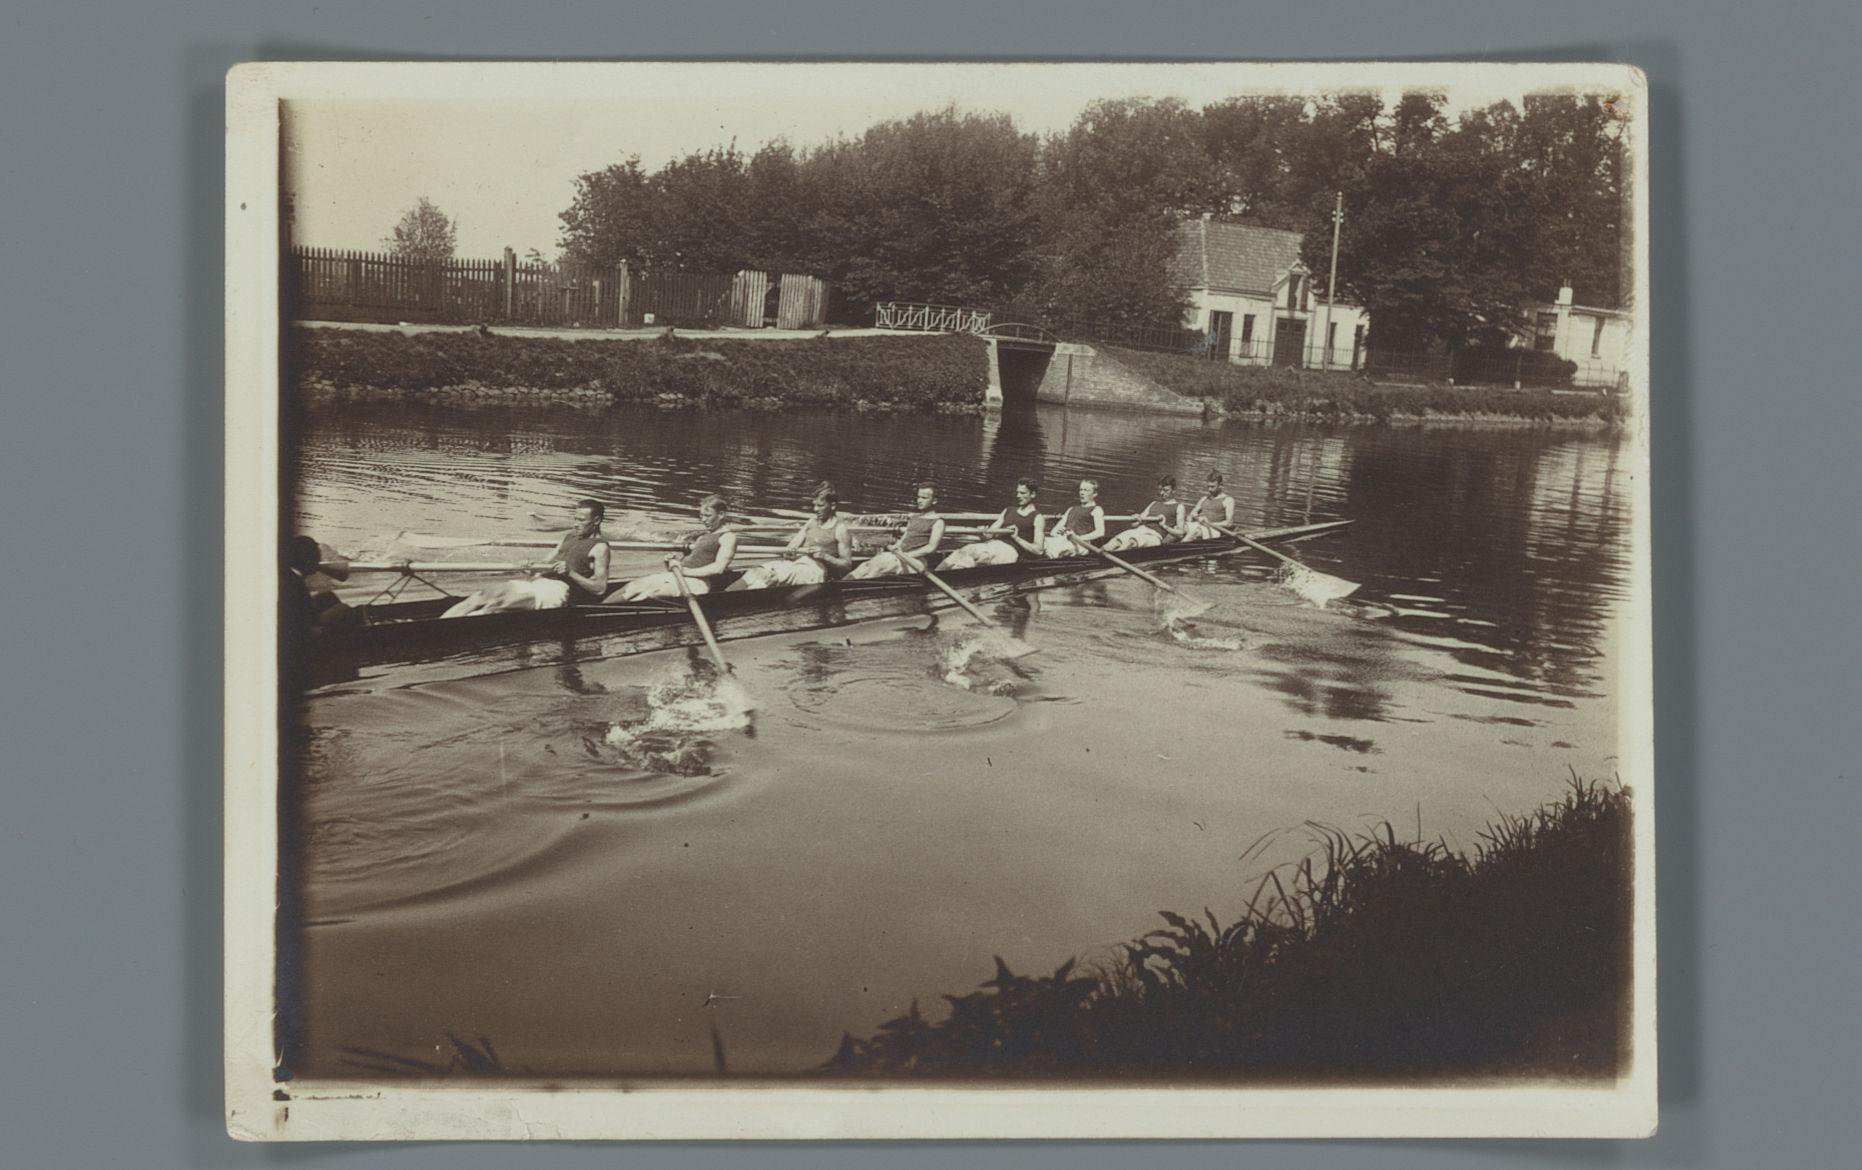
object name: photograph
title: Roeiploeg de Acht met Nap Guldenaar als stuurman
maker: Anonymous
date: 1916-1917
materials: paper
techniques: gelatin silver print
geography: amsterdam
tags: rowing facing backward, pulling, rowing, canoeing, etc. (sport)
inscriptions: copyright notice: ‘COPYRIGHT:/ VEREENIGDE FOTOBUREAUX, AMSTERDAM/ Prinsengracht 868, Tel. N. 856[?]/ 01911’